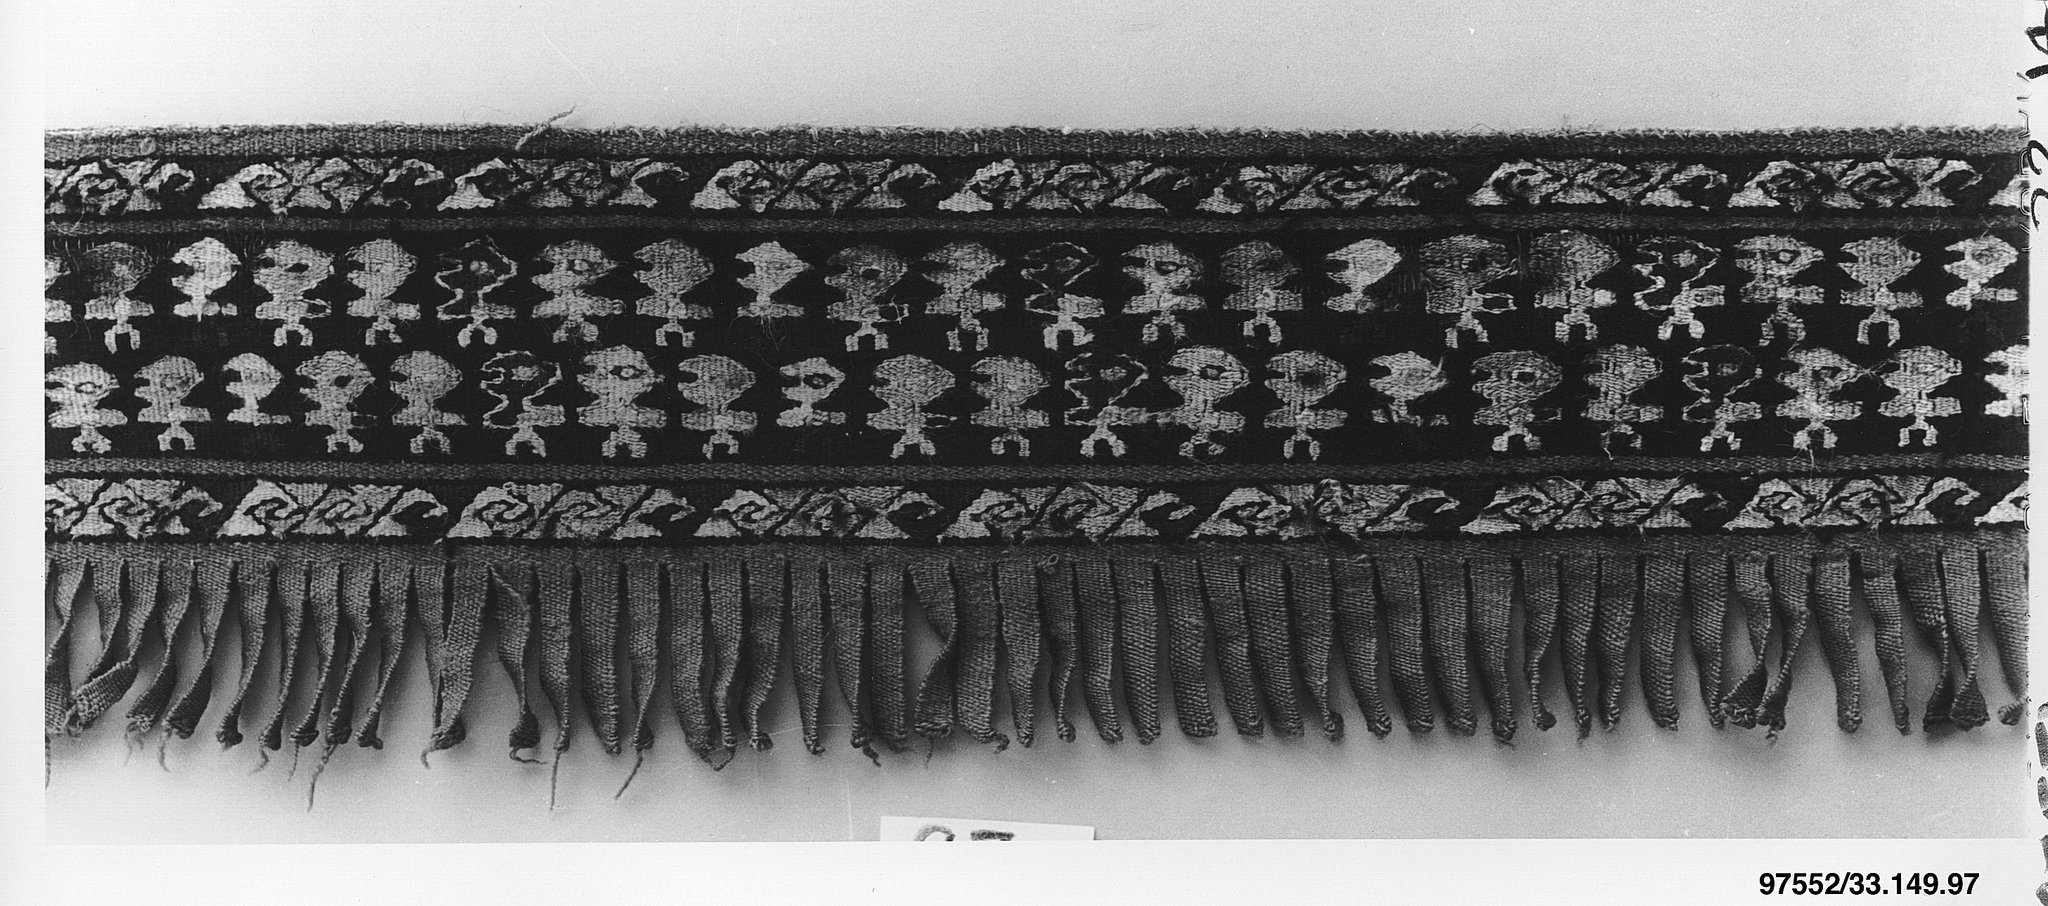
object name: border fragment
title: Tapestry Border Fragment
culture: peruvian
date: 901-1500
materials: animal fiber, cotton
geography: peru